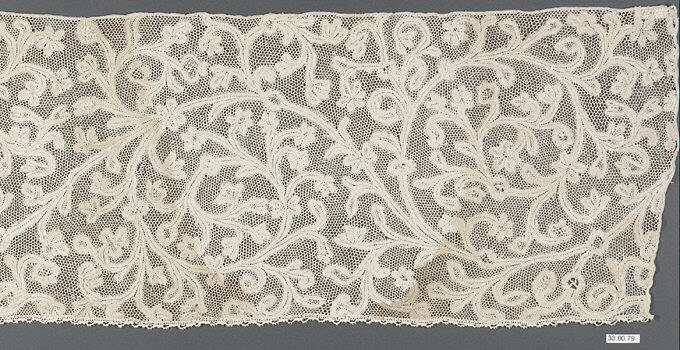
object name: border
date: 1701-1800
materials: lace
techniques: lace